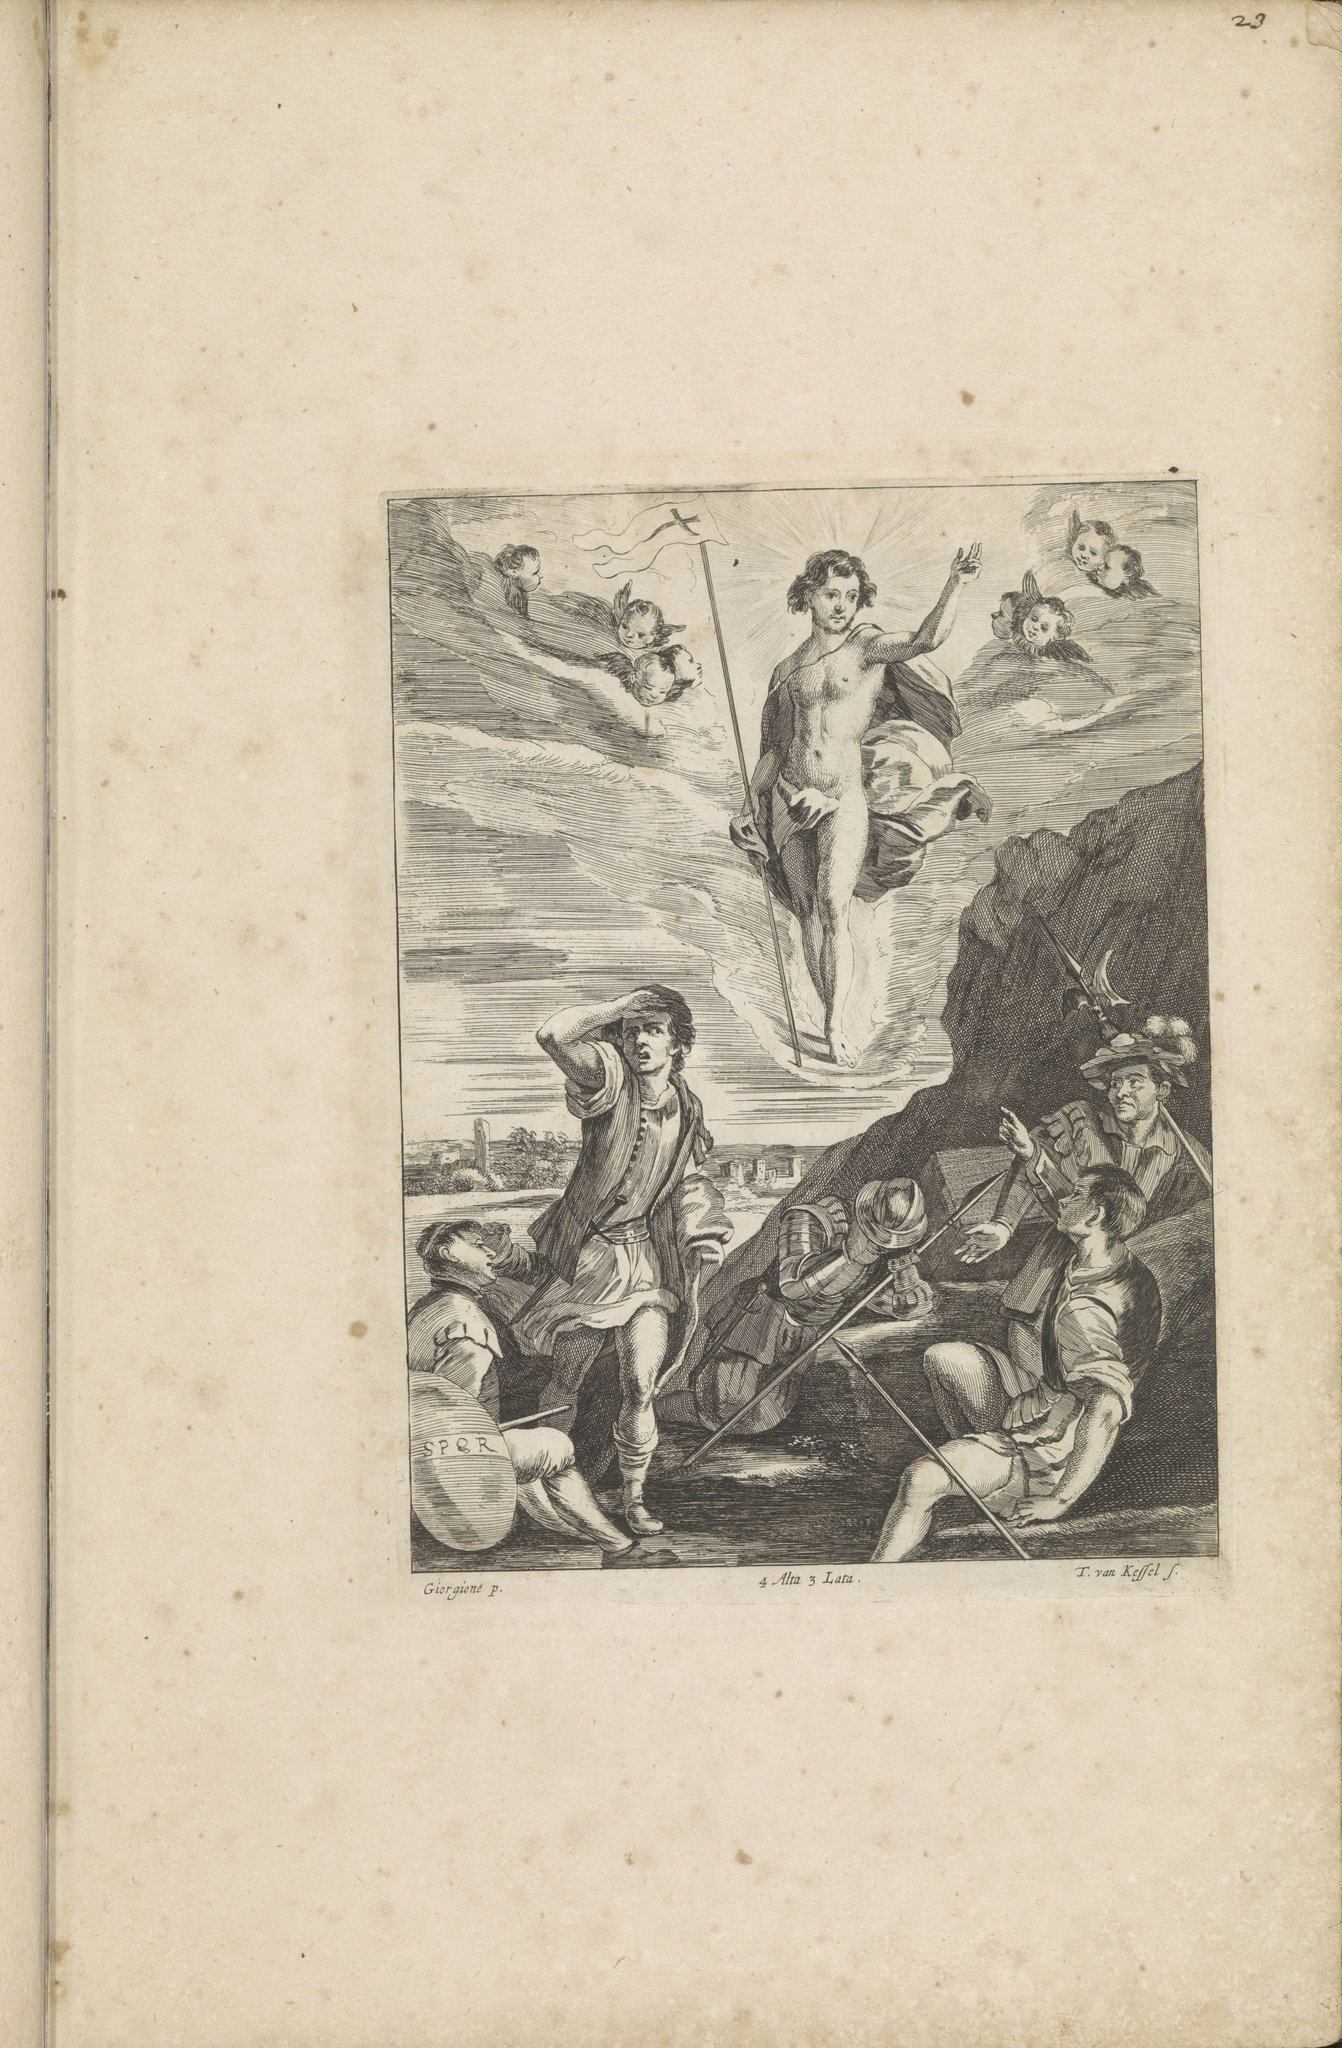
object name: print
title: Opstanding van Christus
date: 1660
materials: paper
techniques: engraving, etching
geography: veneto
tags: christ, usually holding a banner, arises from the grave; often combined with sleeping and/or frightened soldiers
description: Prent naar een schilderij van een Venetiaanse schilder dat zich in de collectie van het Kunsthistorisches Museum te Wenen bevindt (inventarisnummer GG_347). David Teniers heeft waarschijnlijk van alle schilderijen uit de collectie van Leopold Willem van Oostenrijk een olieverfstudie op doek of paneel vervaardigd (zgn. pasticcio), die als voorbeeld voor de prentmakers diende. Het is niet altijd duidelijk of de pasticci door hem zijn gemaakt of door zijn atelier. Niet alle pasticci zijn overgeleverd.